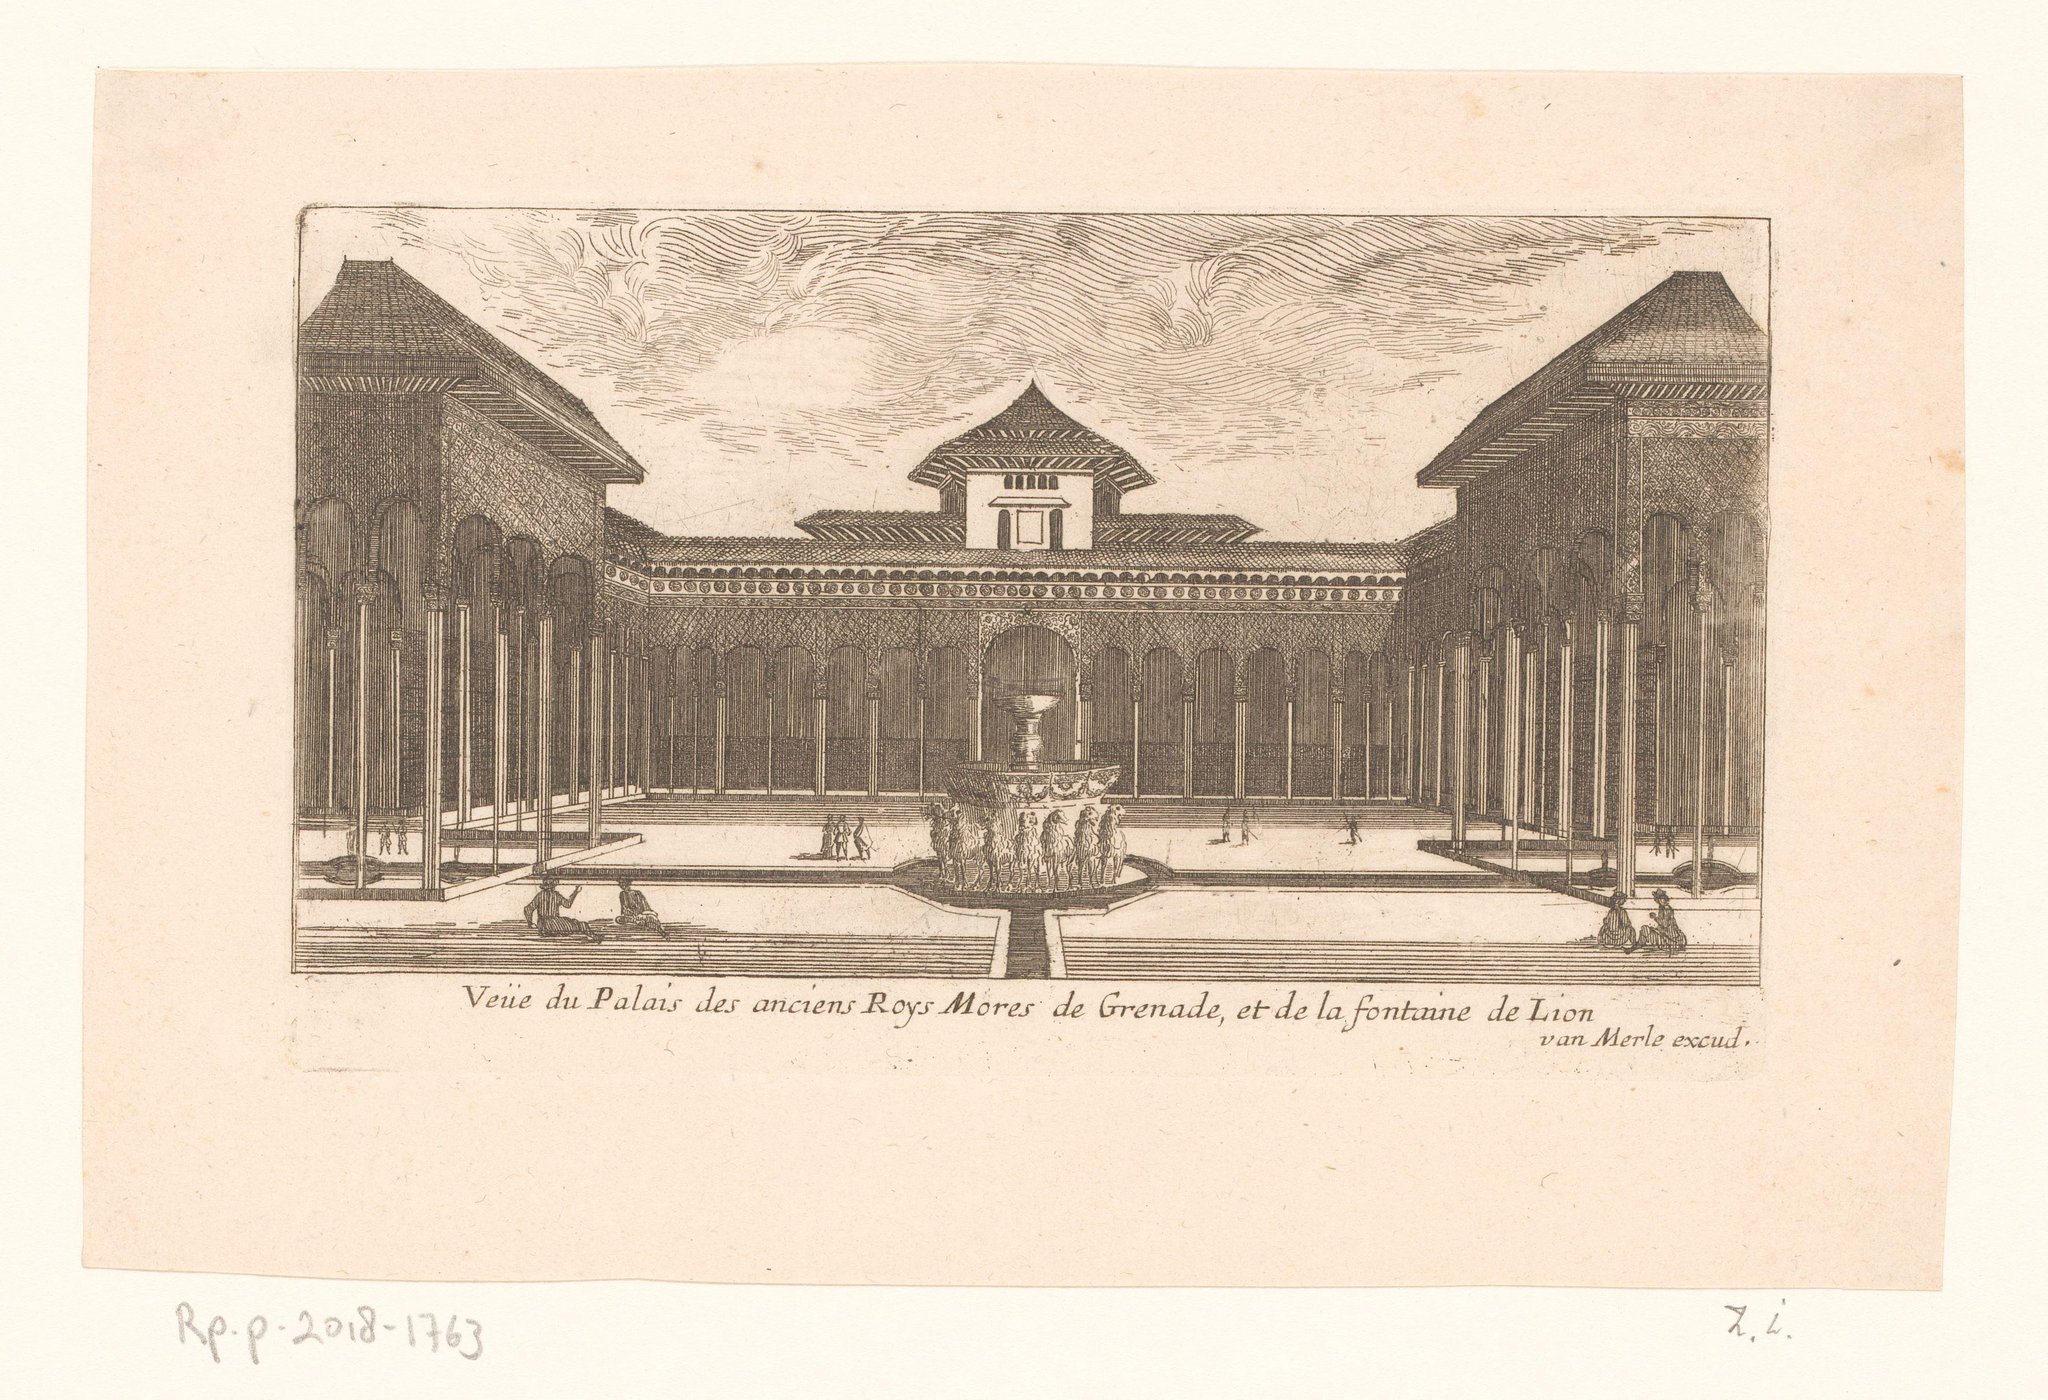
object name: print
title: Gezicht op Alhambra, in Granada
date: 1626-1686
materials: paper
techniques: etching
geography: antwerp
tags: garden fountain, palace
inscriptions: collector's mark: Lugt 2228